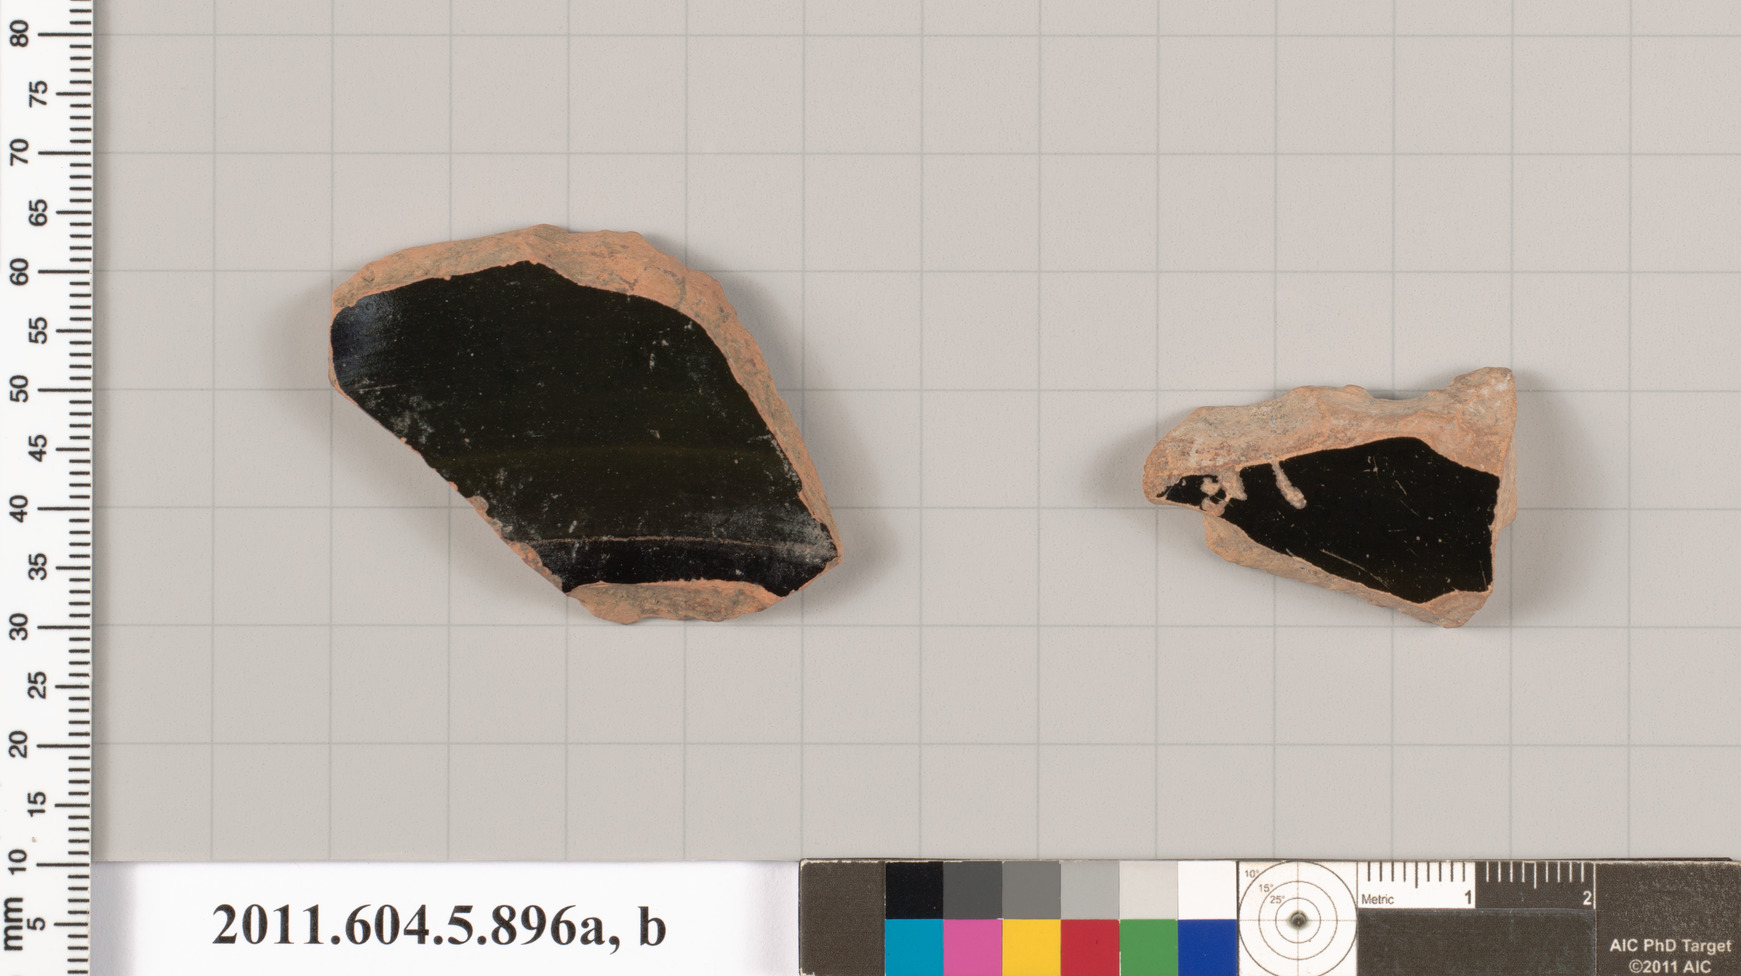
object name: kylix fragment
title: Terracotta fragments of kylikes (drinking cups)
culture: greek, attic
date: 600-401 BCE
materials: terracotta